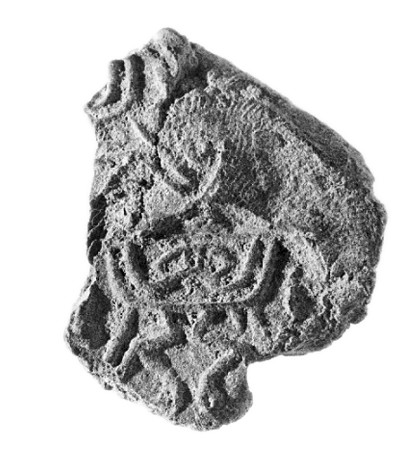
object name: sealing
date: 1981-1640 BCE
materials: mud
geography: egypt